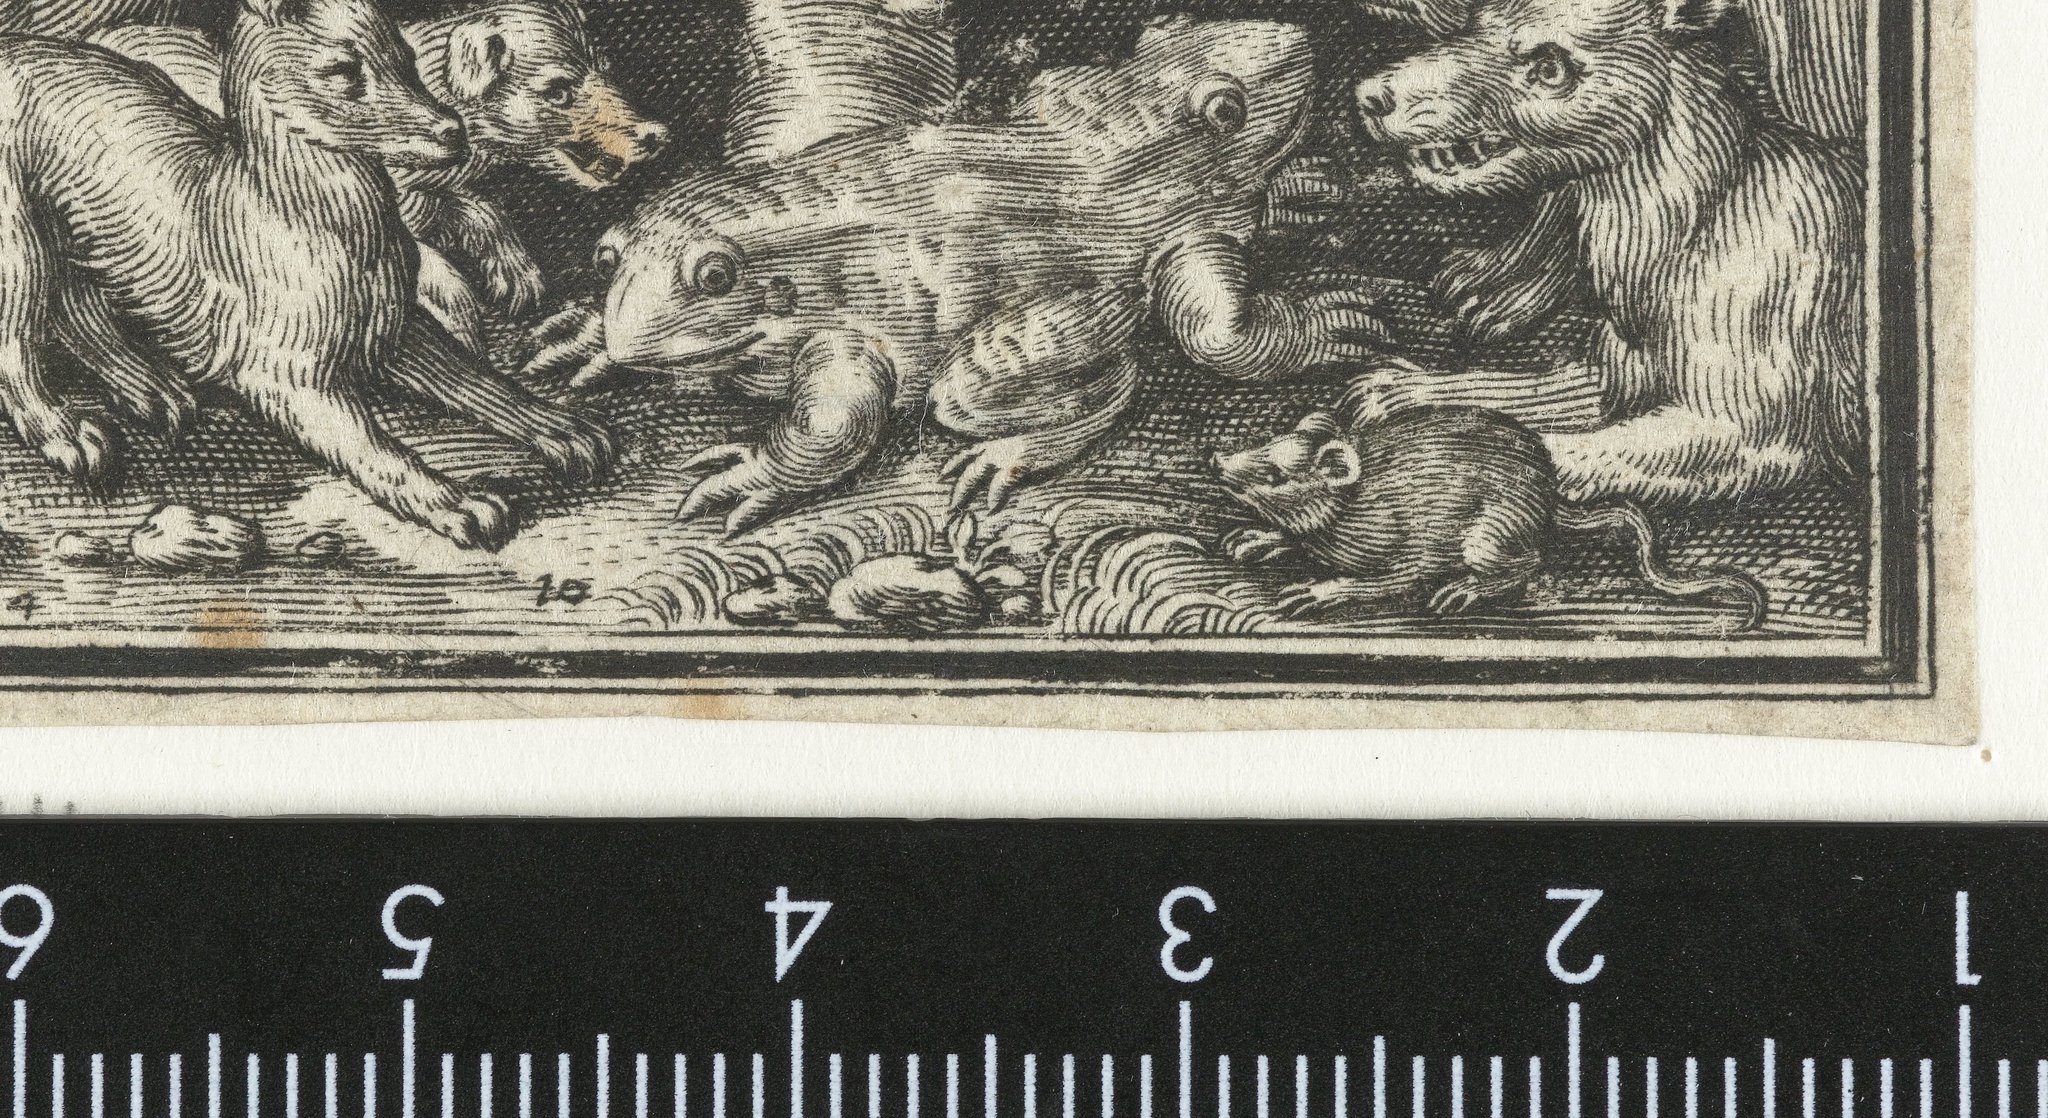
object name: print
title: Dieren uit fabels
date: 1594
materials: paper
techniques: engraving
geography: netherlands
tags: tailless amphibians: frog, tailless amphibians: toad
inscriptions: collector's mark: Lugt 2228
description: R. de Rosey nr. 194. Prent uit serie van twaalf kleine prentjes met vechtende chimeras en dieren uit Aisopische fabels. Eenzelfde serie is ook uitgegeven door Visscher (Fuhring, 1989).